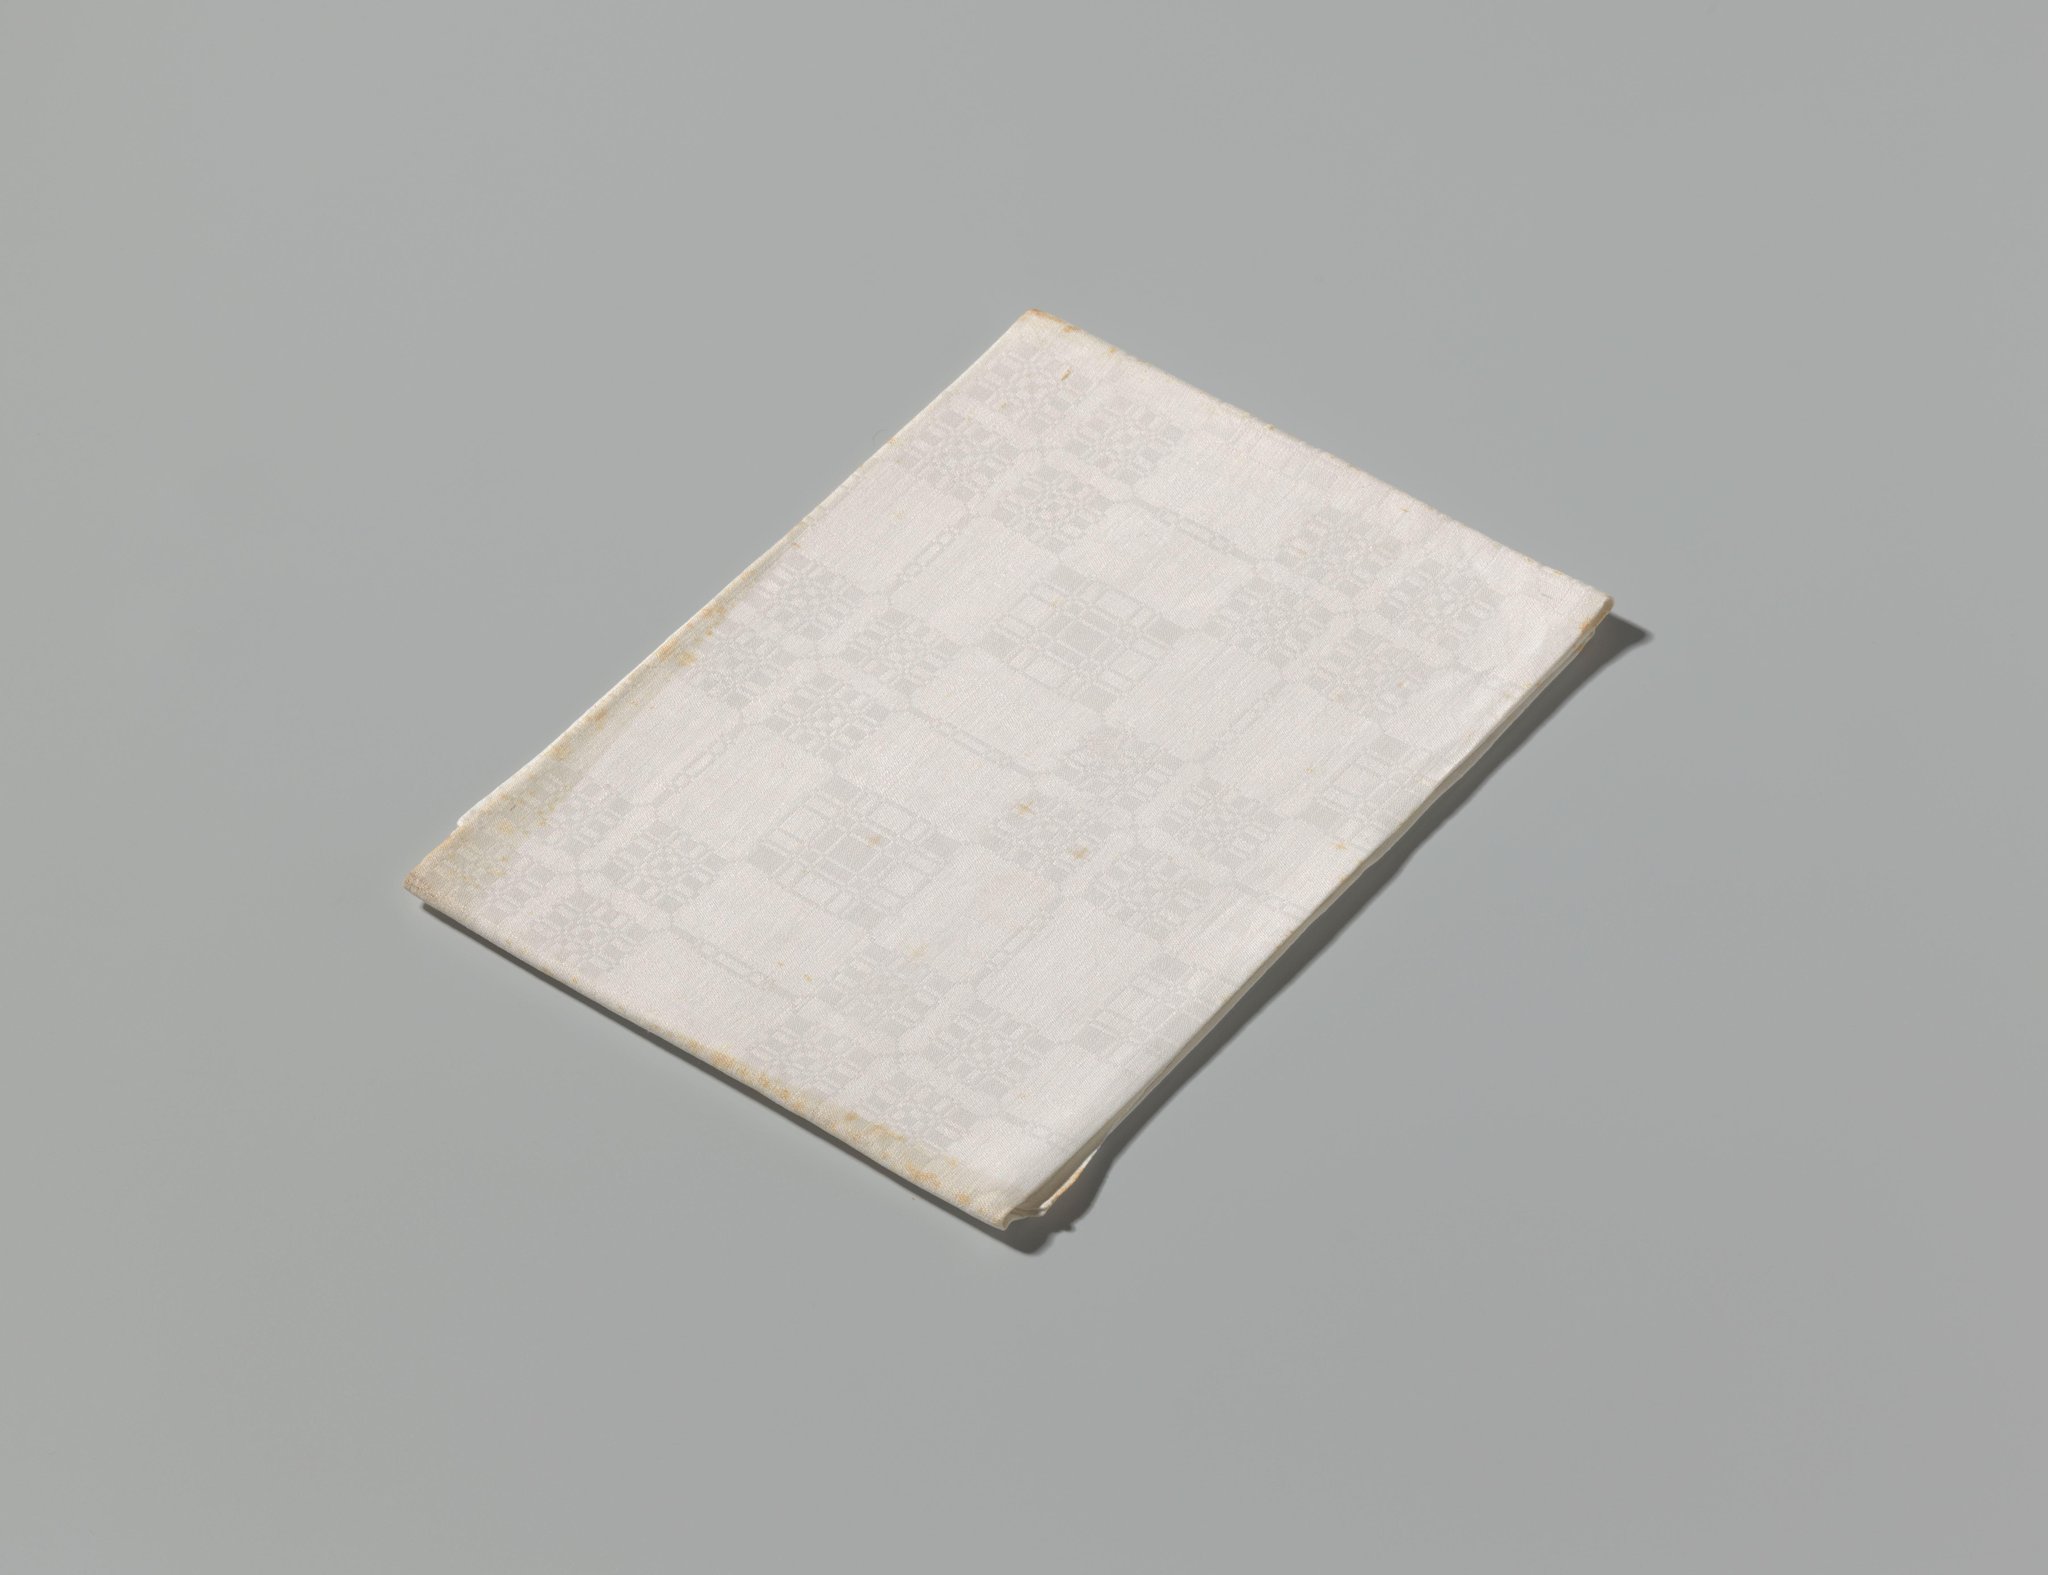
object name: napkin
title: Servet van pellendamast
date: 1700-1800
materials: linen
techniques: weave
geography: northern netherlands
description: Servet van linnen pellendamast. Het geblokte patroon heeft vierkanten bestaande uit kleinere vierkanten en lijnen. De randen zijn gestreept. Het servet heeft een aangenaaid nummer 1193 in rood op wit.